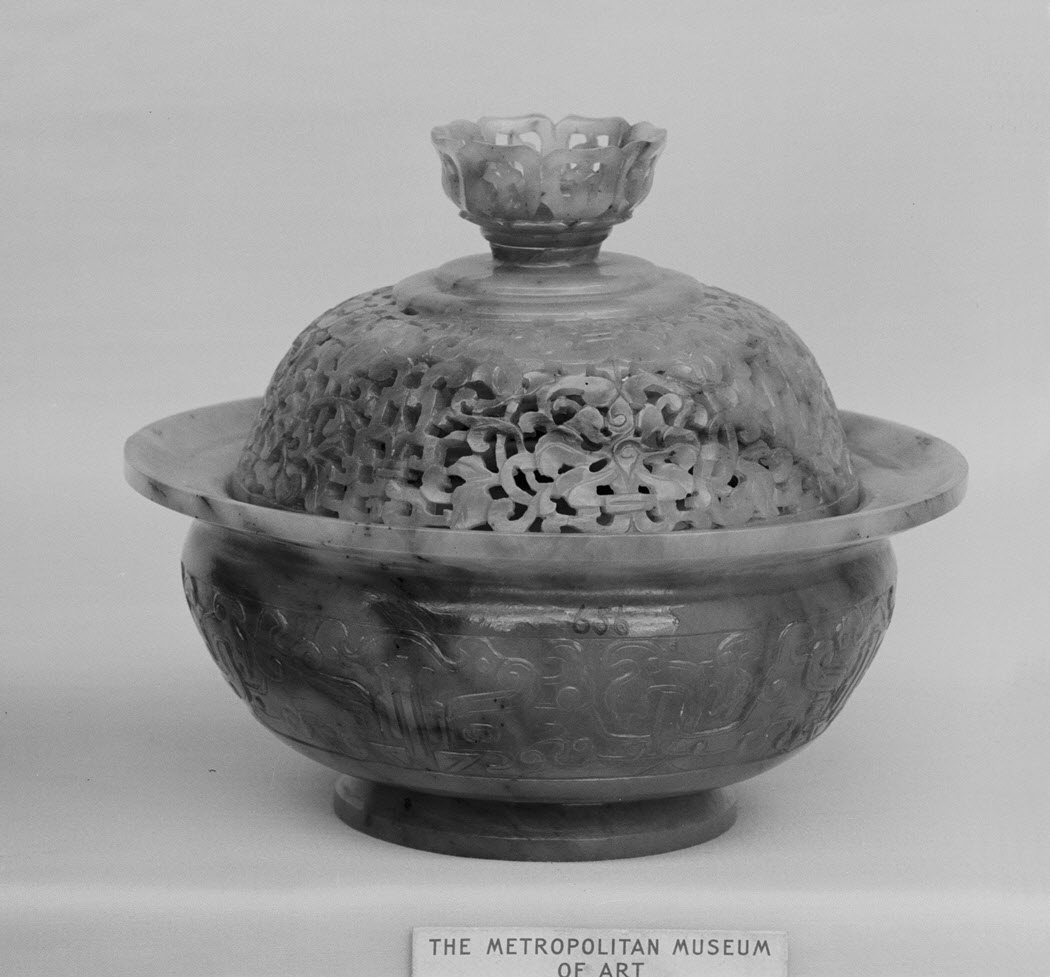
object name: incense burner with cover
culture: chinese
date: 1736-1795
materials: jade